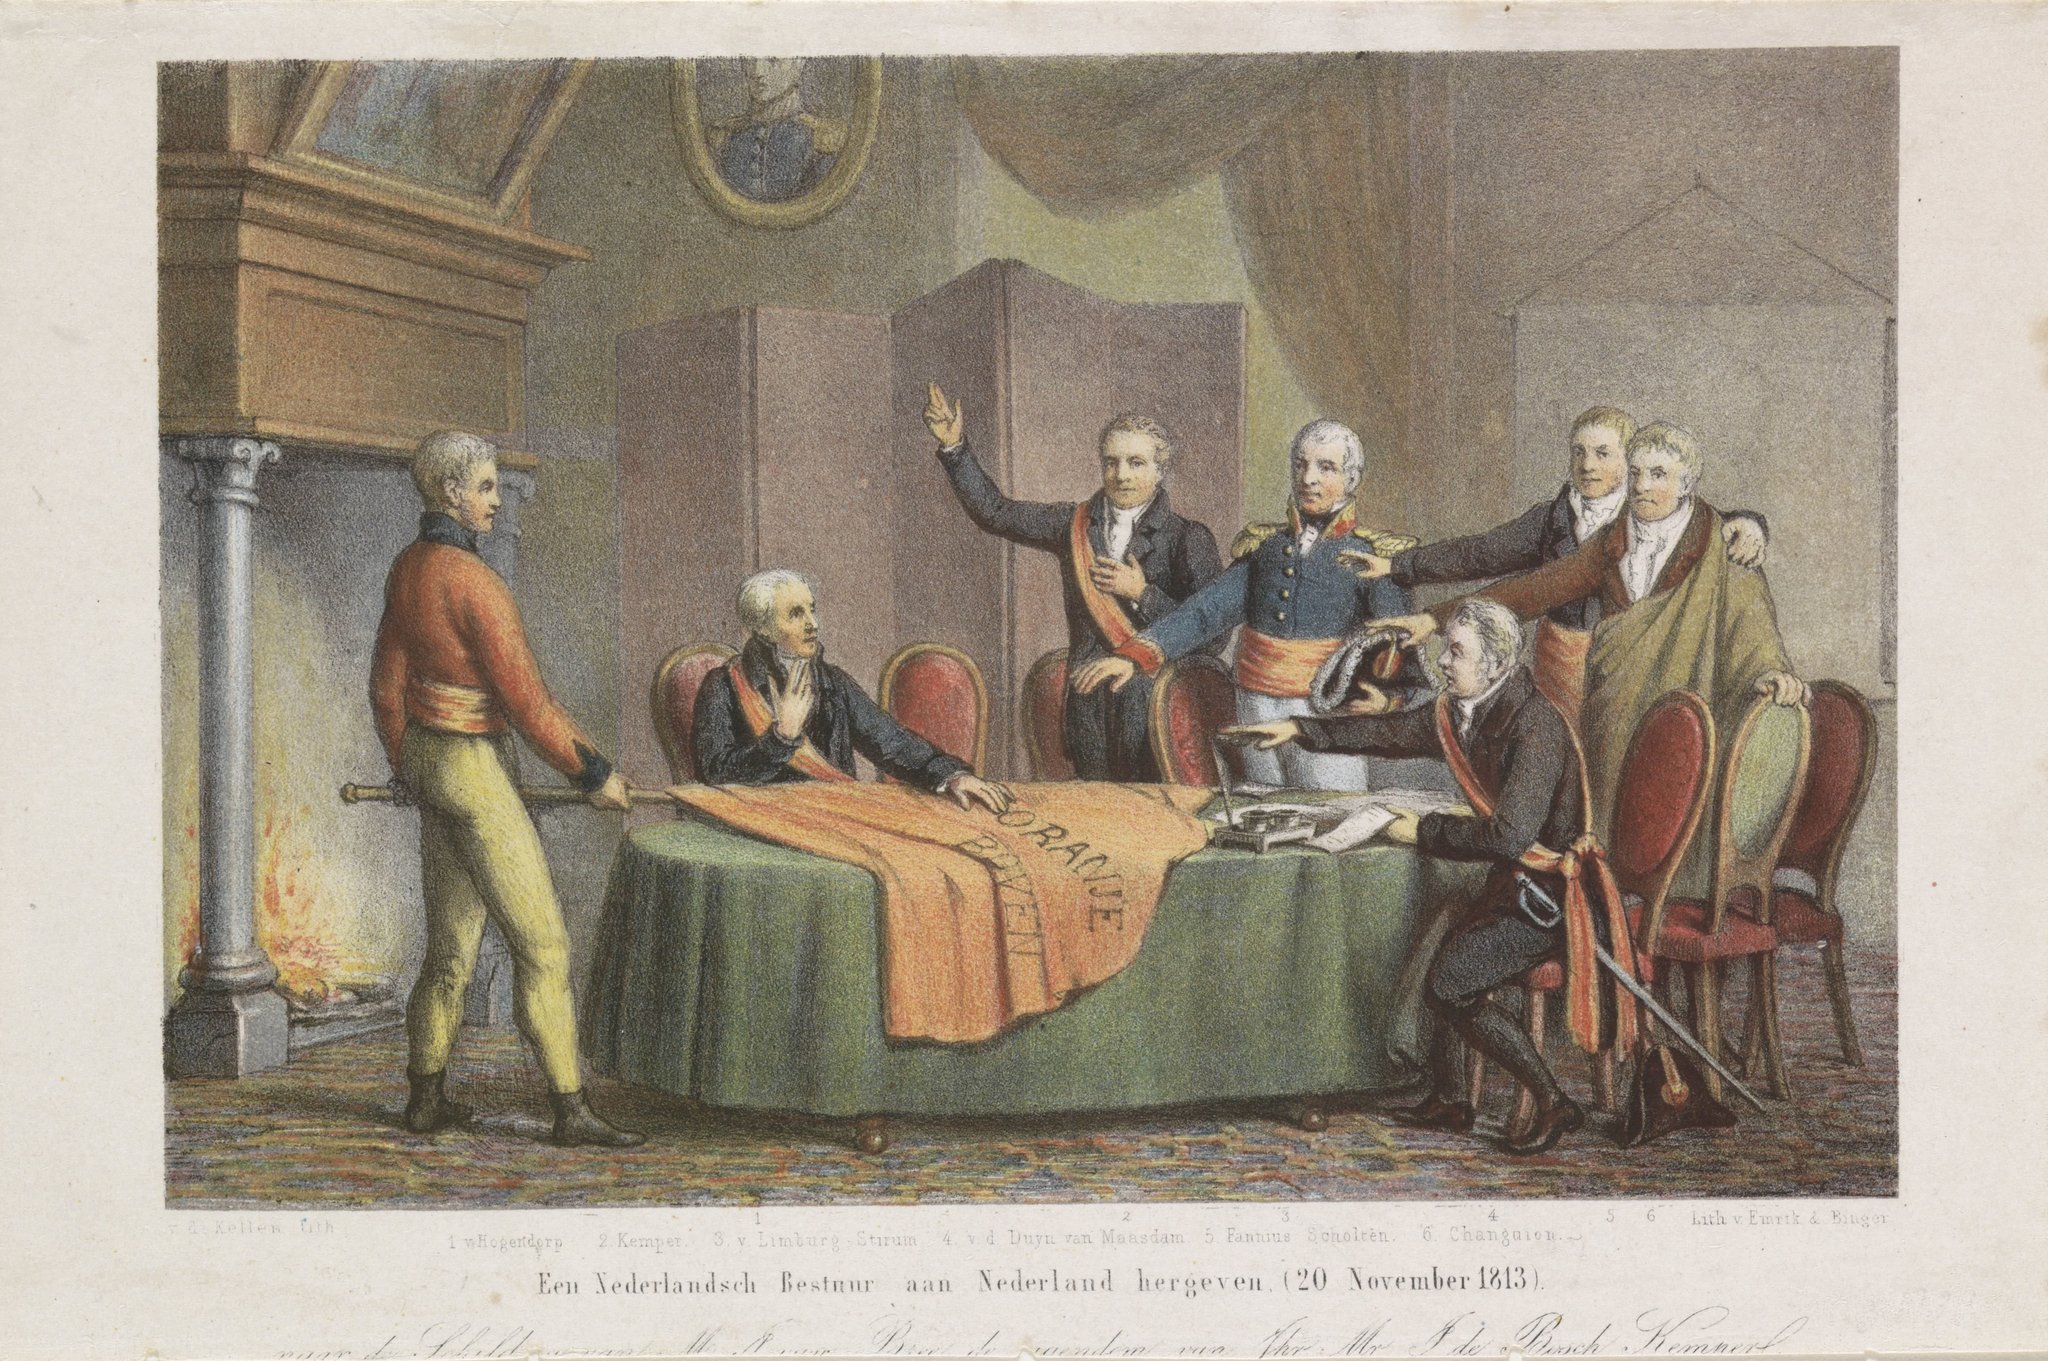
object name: print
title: Aanvaarding van het Hoog Bewind door het Driemanschap in naam van de prins van Oranje, 21 november 1813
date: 1863-1865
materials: paper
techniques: lithograph, hand coloring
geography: haarlem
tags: the hague, berlin, william i of the netherlands, rotterdam, gijsbert karel graaf van hogendorp, lille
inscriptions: collector's mark: Lugt 2228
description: De aanvaarding van het Hoog Bewind door het Driemanschap in naam van de prins van Oranje door A.F. van der Duyn, G.K. van Hogendorp en L. van Limburg Stirum namens de prins van Oranje, Den Haag, 21 november 1813. Samenkomst ten huize van Van Hogendorp waarbij de eed op een Oranjevlag wordt afgelegd, hierbij zijn ook aanwezig: Kemper, Fannius Scholten en F.D. Changuion.